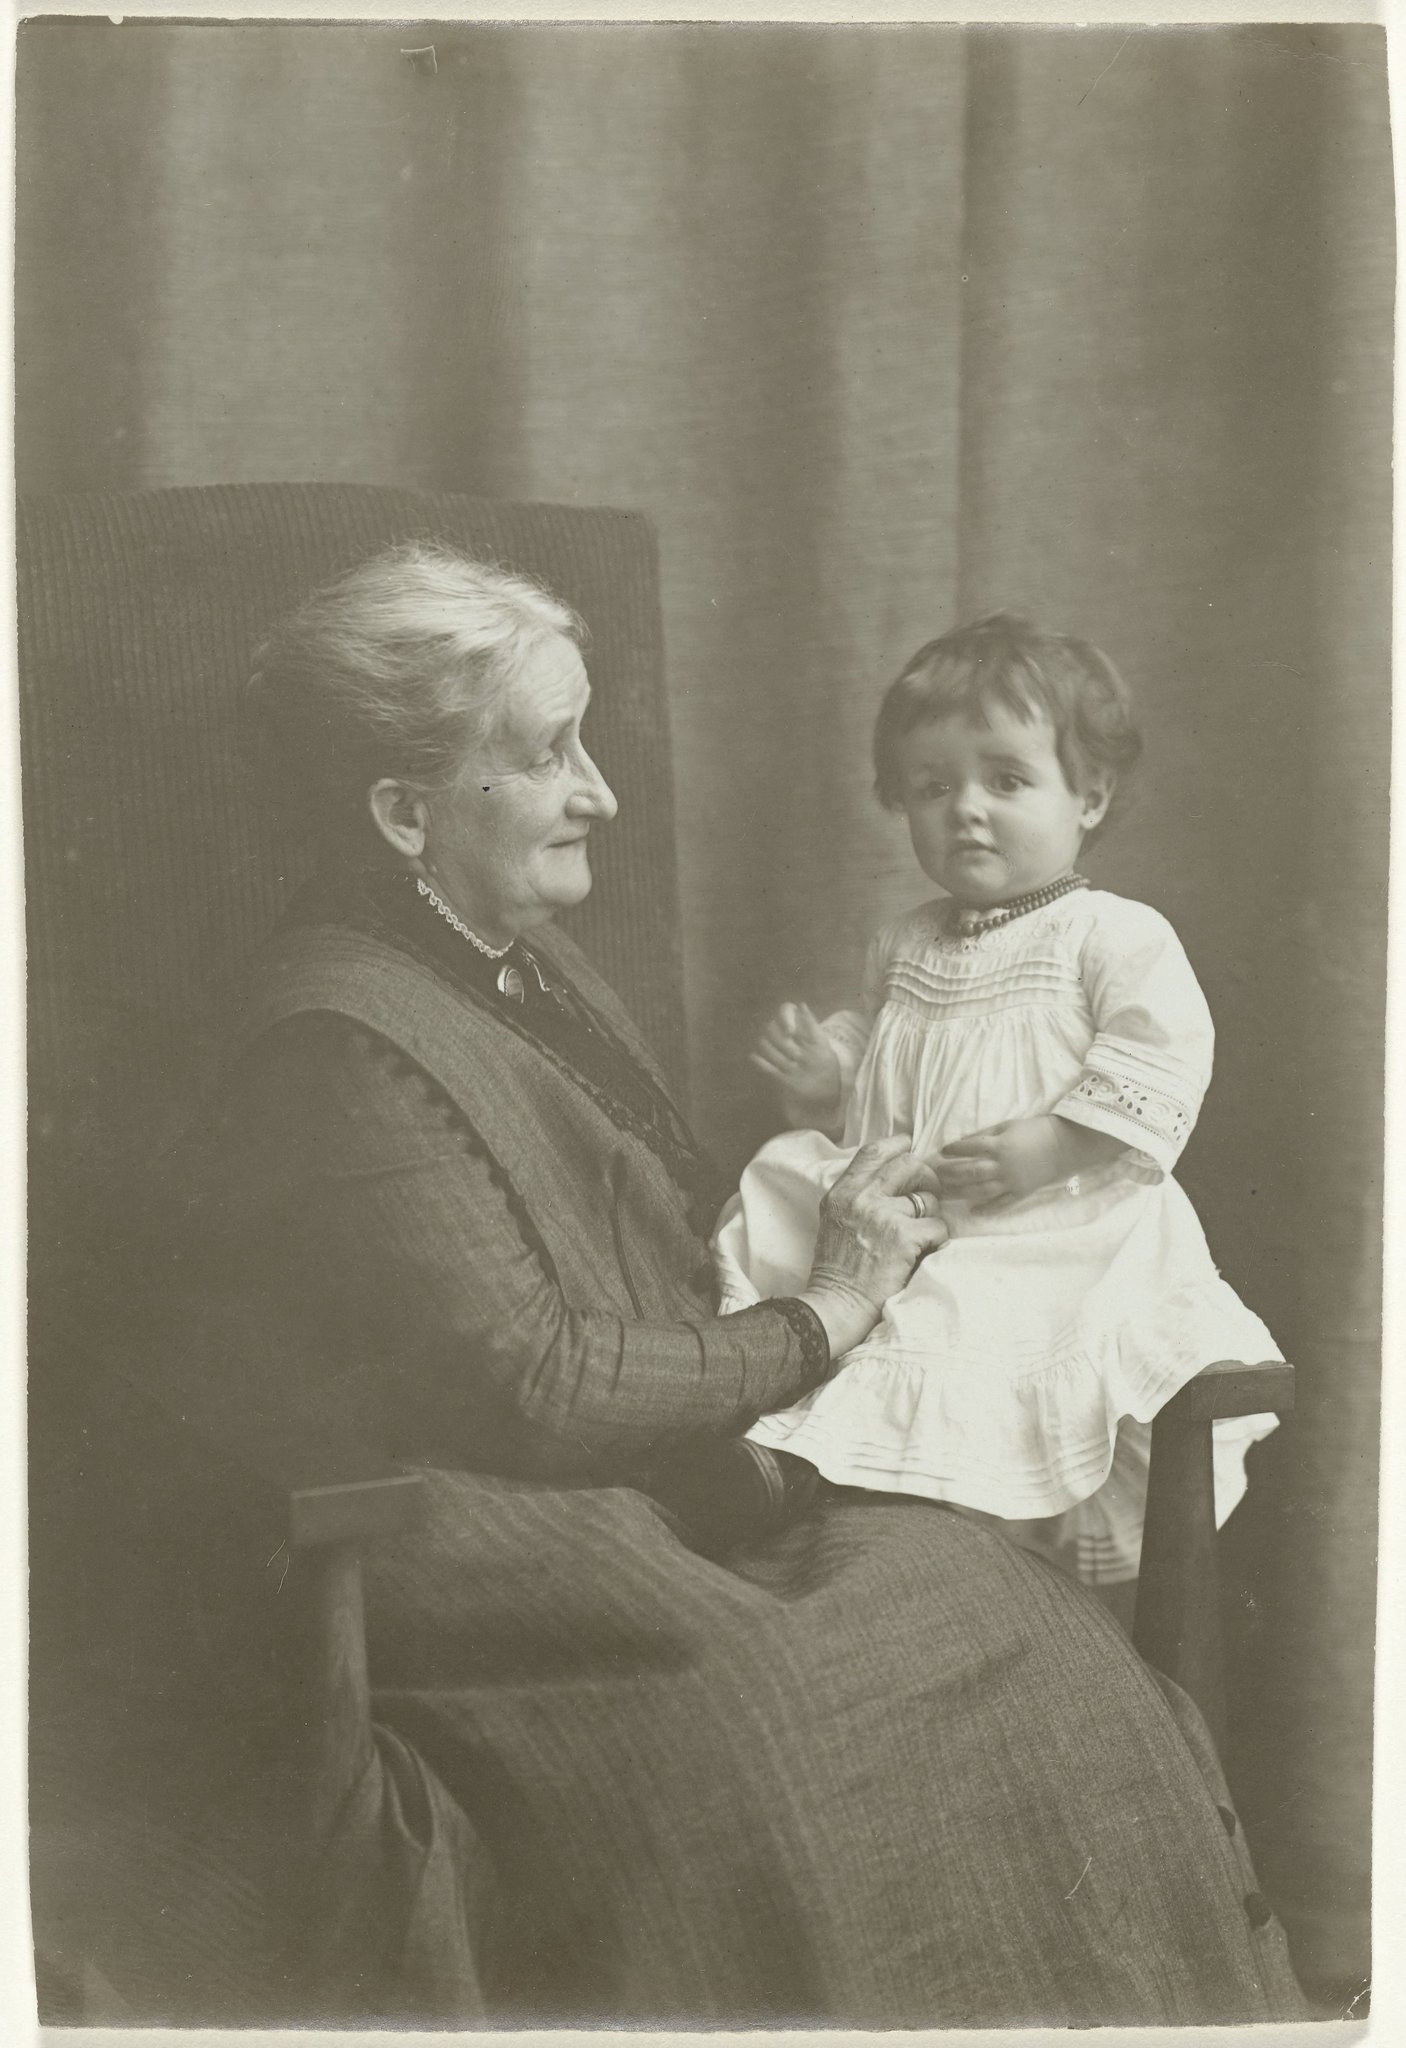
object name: photograph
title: Marba Titzenthaler, dochter van de fotograaf, met een onbekende oude vrouw, waarschijnlijk haar grootmoeder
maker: waldemar titzenthaler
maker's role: fotograaf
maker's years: 1869-1937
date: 1912-1913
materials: paper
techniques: gelatin silver print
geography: germany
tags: grandparent(s) with grandchild(ren) (family group), tot, toddler ~ the ages of man, germany